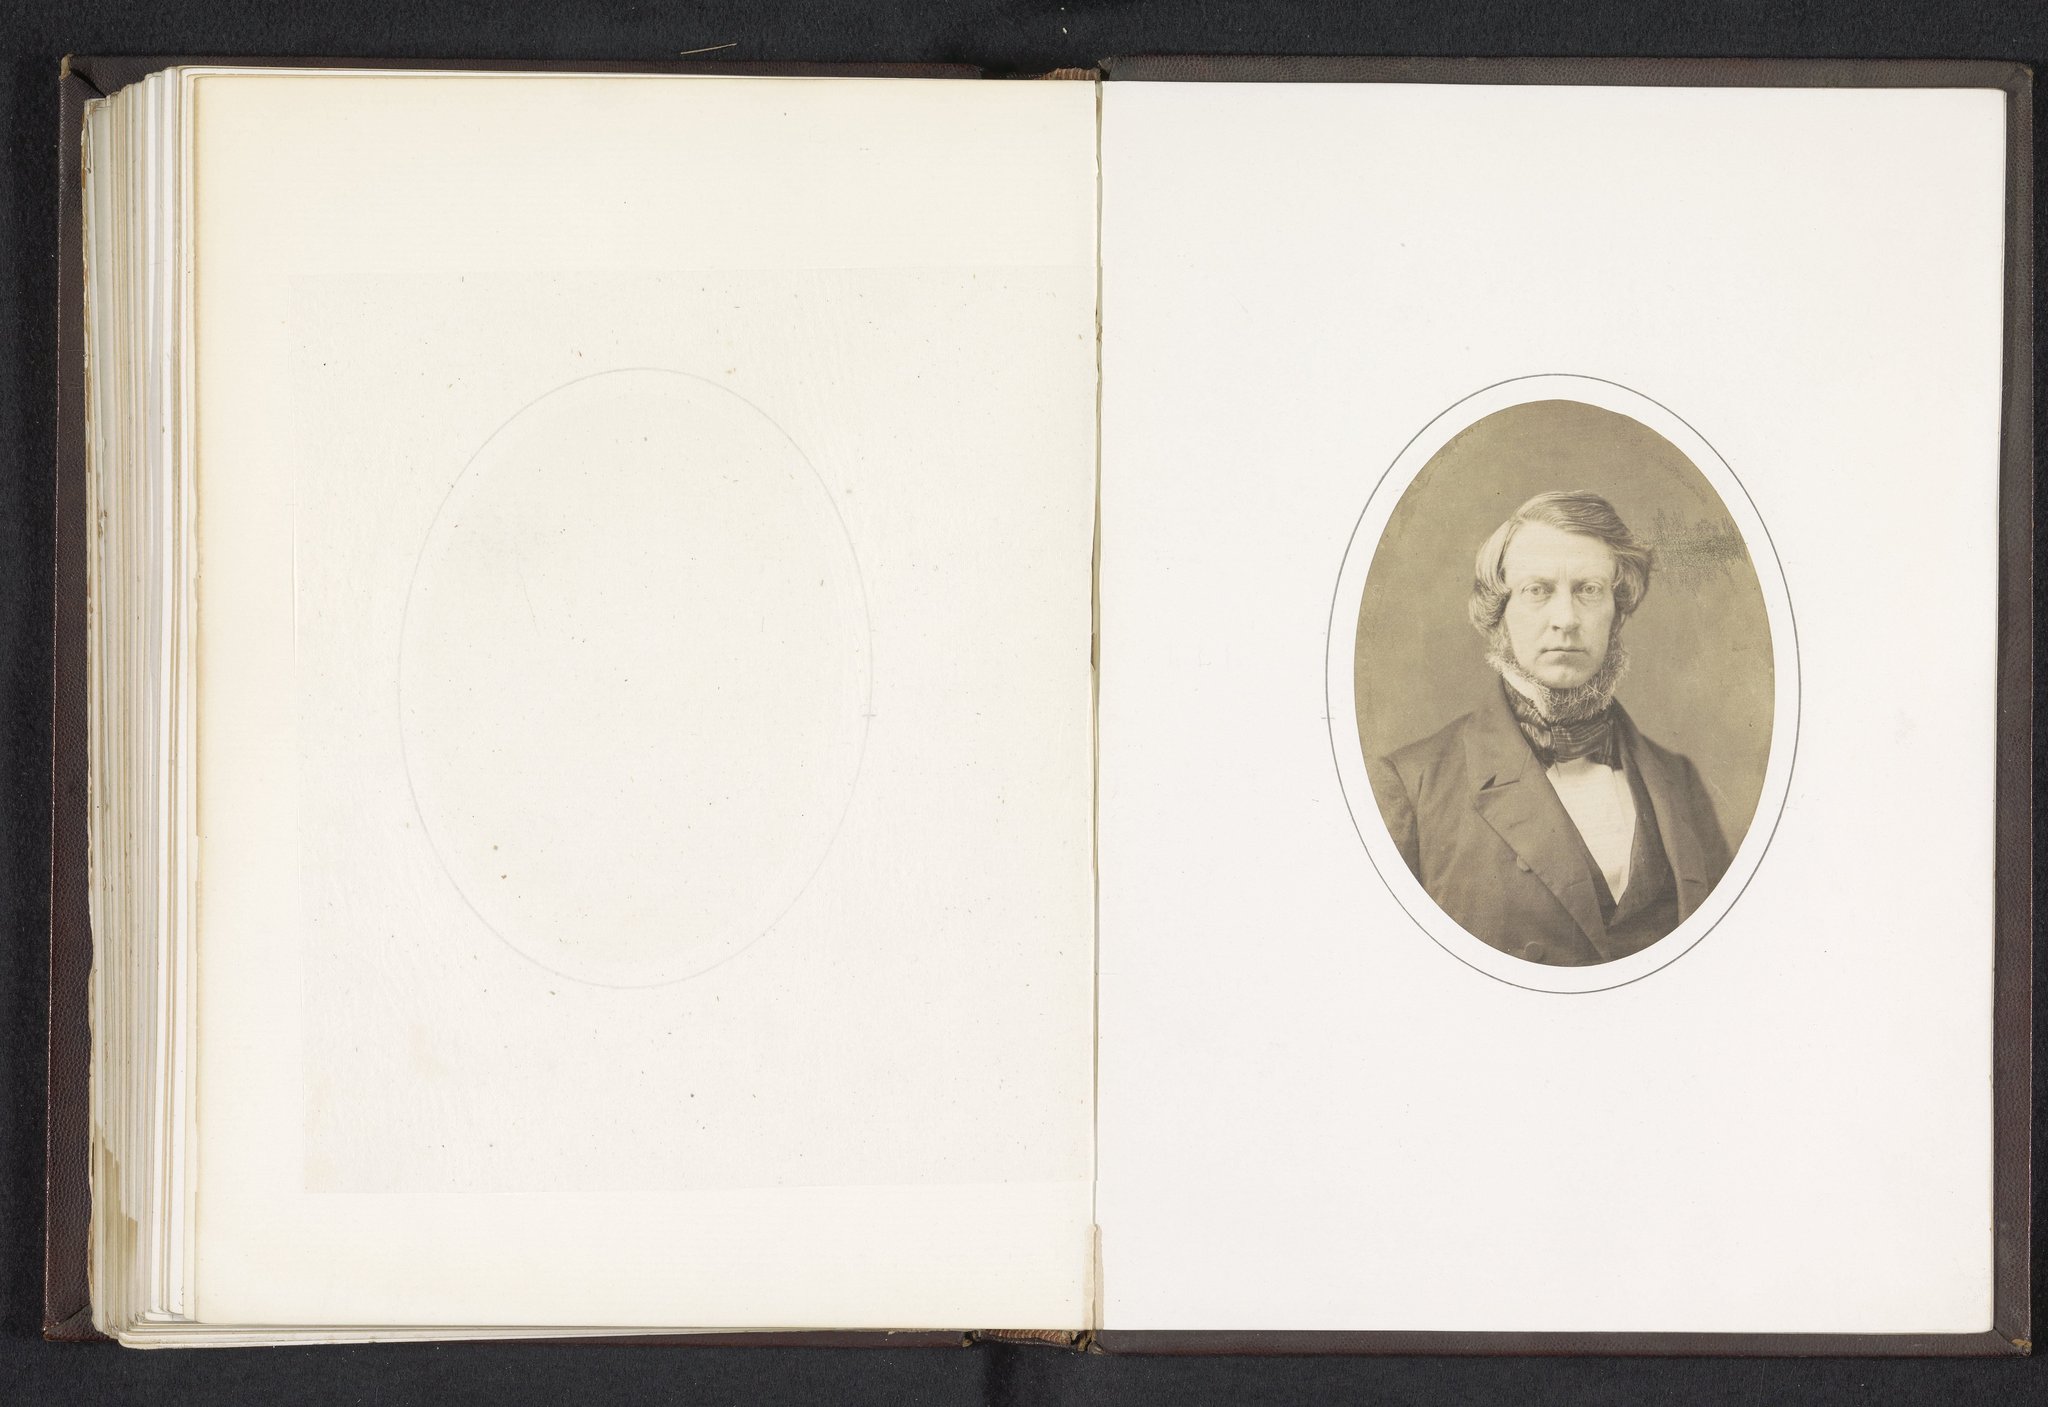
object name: photograph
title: Portret van een onbekend Senaatslid van de staat New York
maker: d.t.t. davie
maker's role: publisher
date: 1858-1859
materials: photographic support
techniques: salted paper print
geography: new york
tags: politician, e.g. party leader, upper house, senate, historical persons not known by name